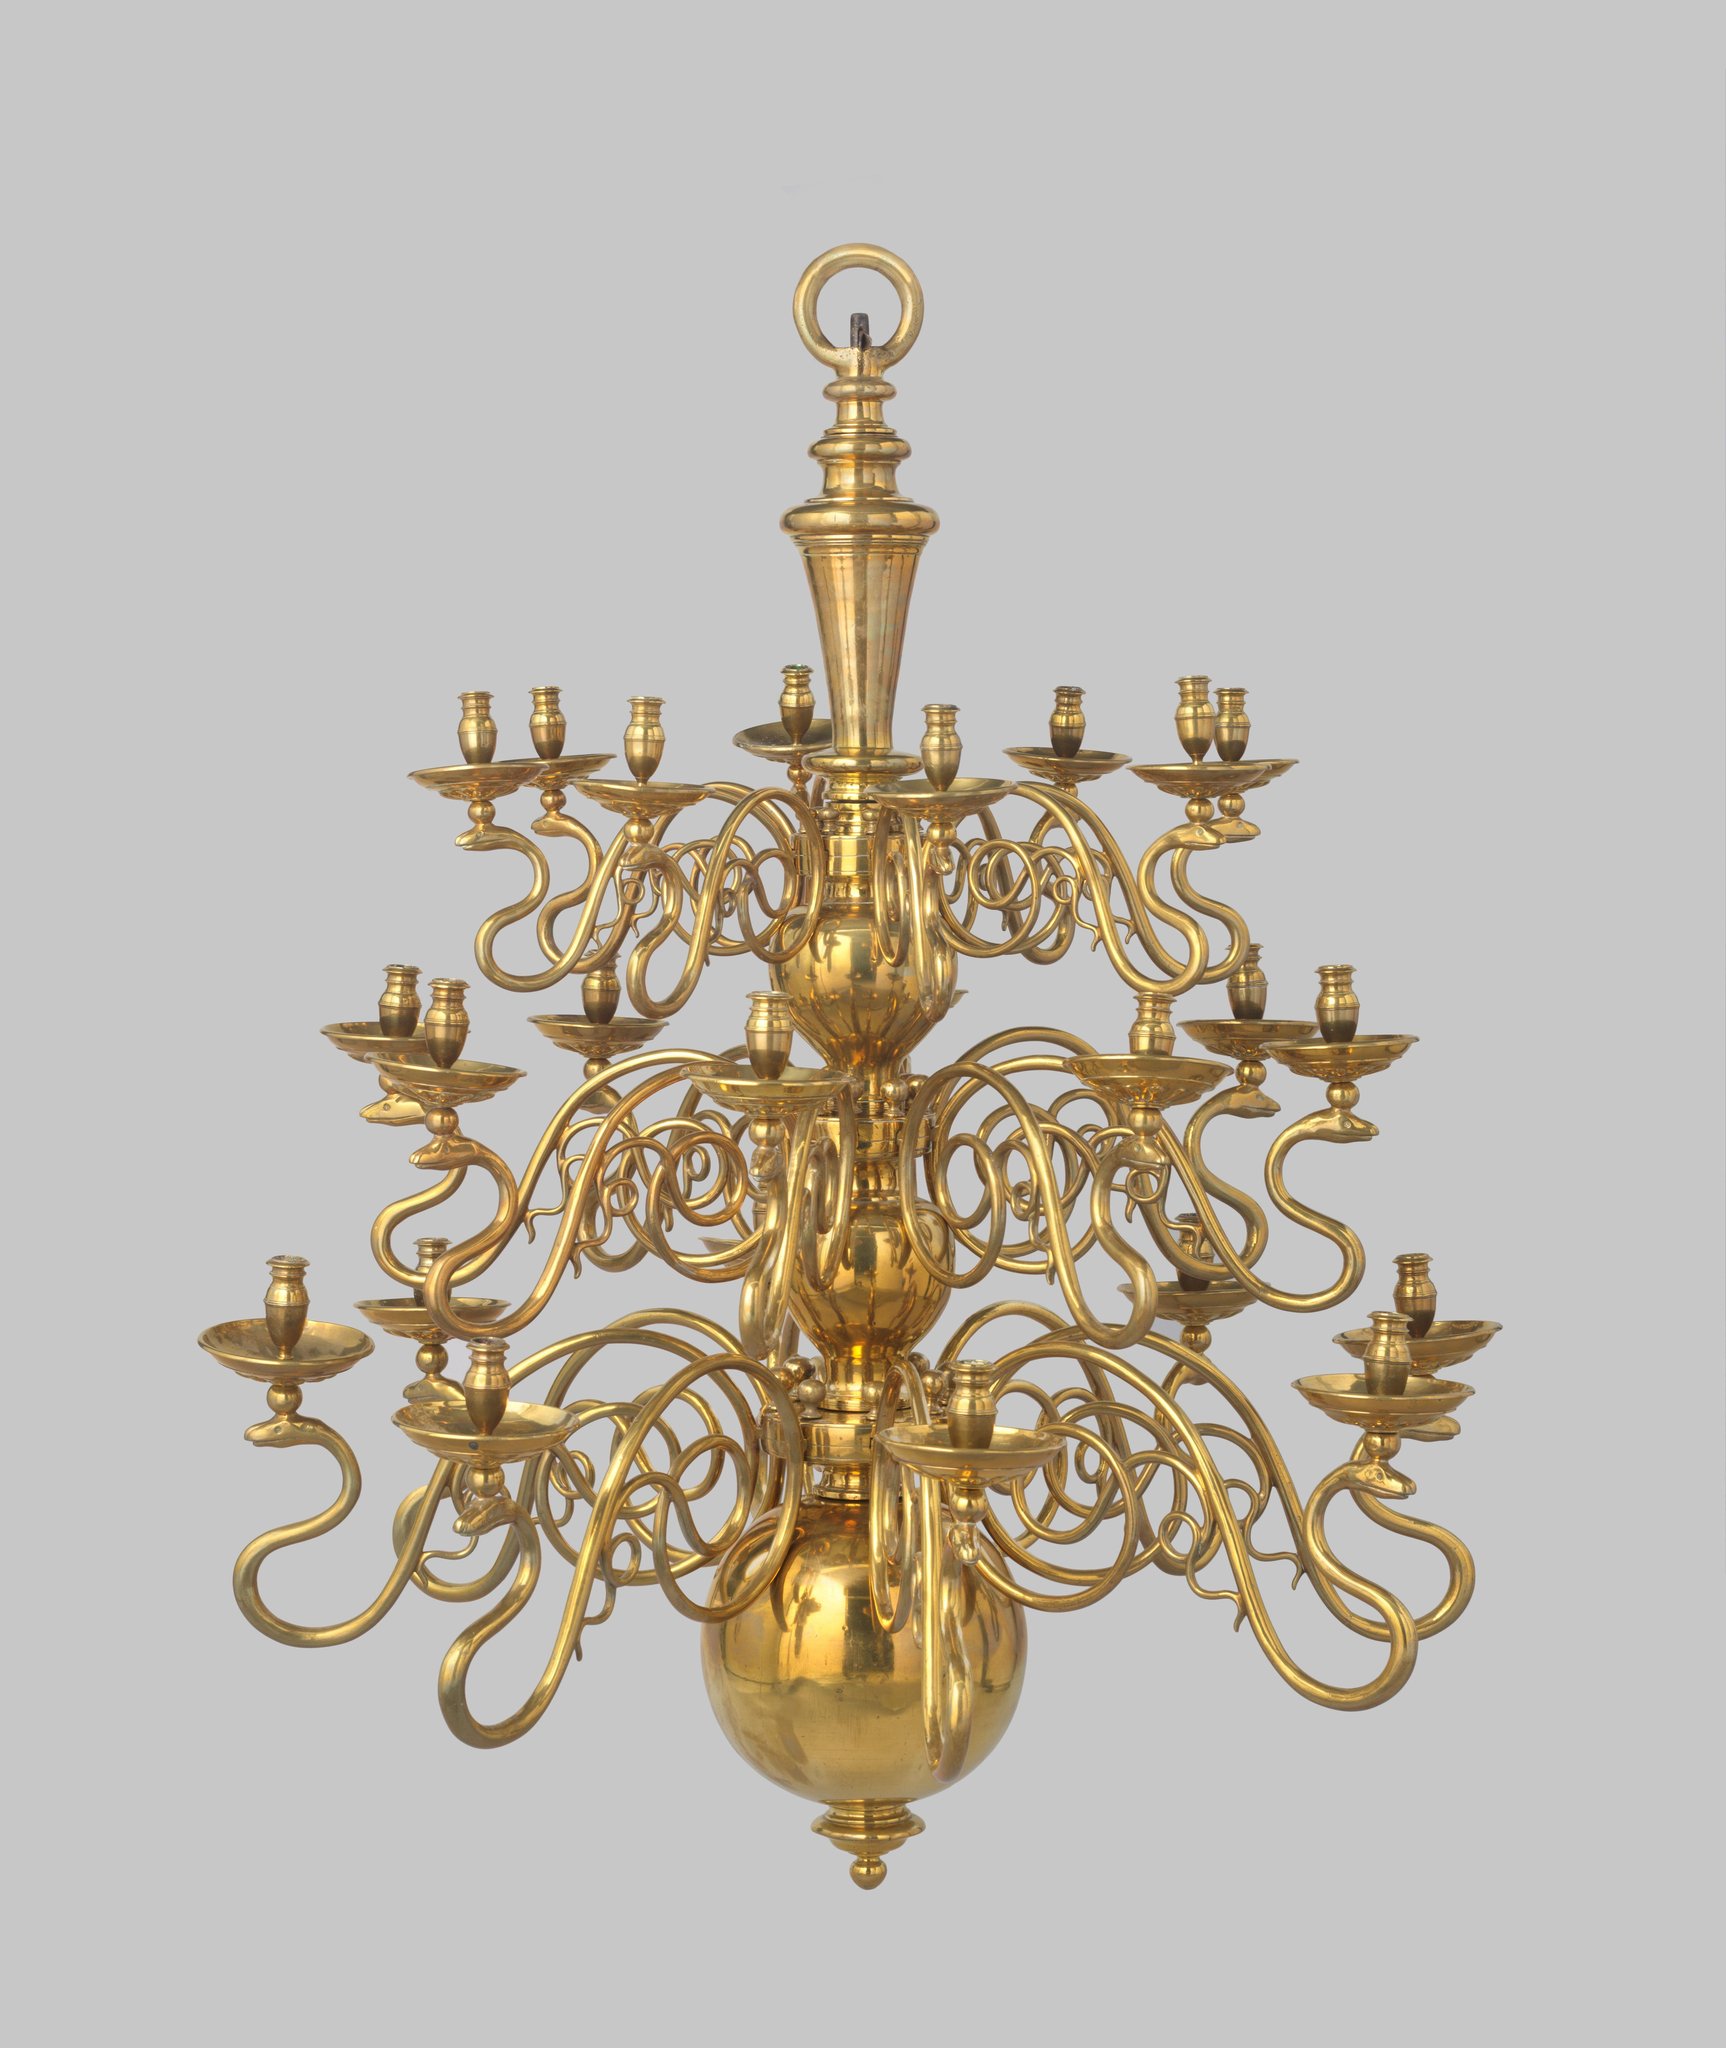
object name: chandelier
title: Kaarsenkroon van drie hoogten met ieder acht armen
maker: Anonymous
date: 1650-1700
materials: metal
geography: netherlands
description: Kaarsenkroon van drie hoogten met ieder acht armen, van messing en ijzer.